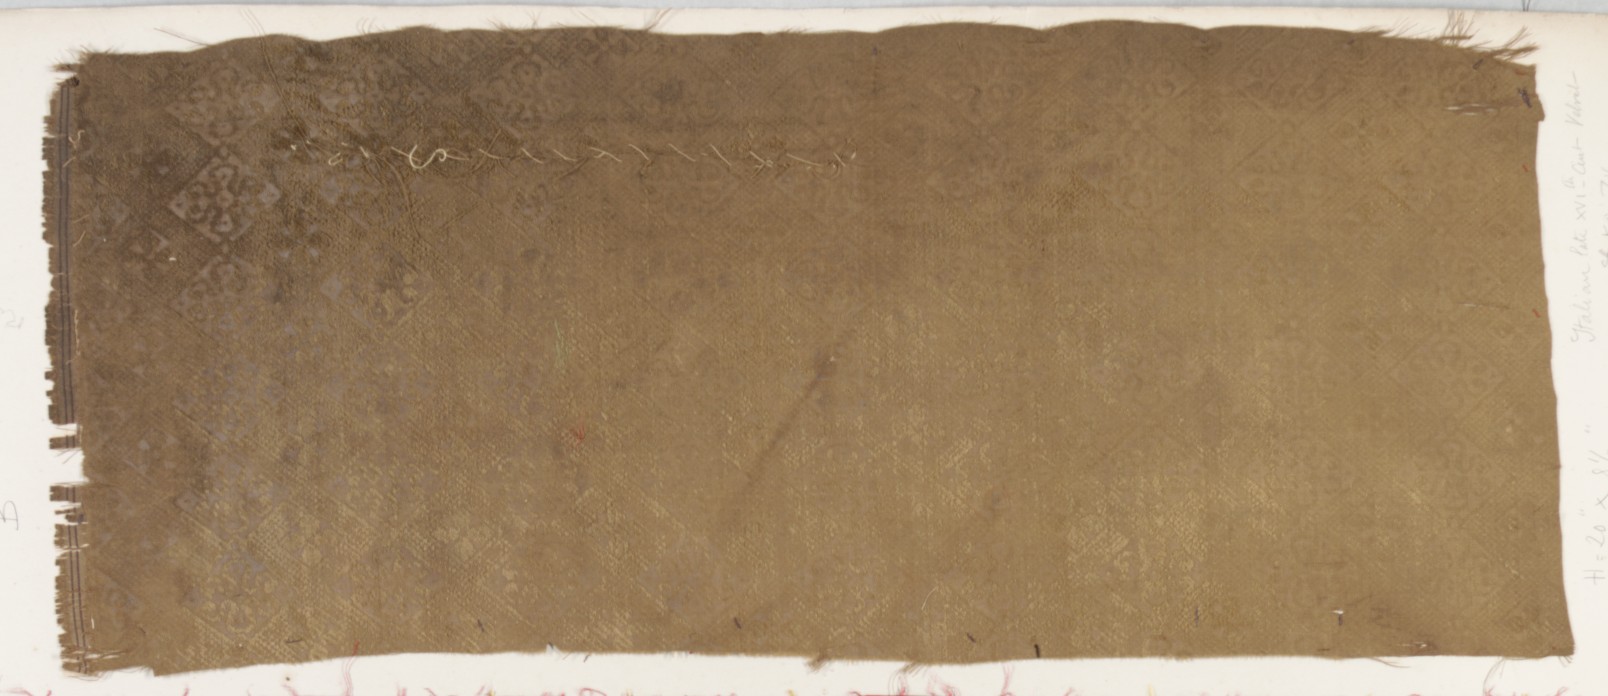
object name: fragment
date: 1567-1600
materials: silk